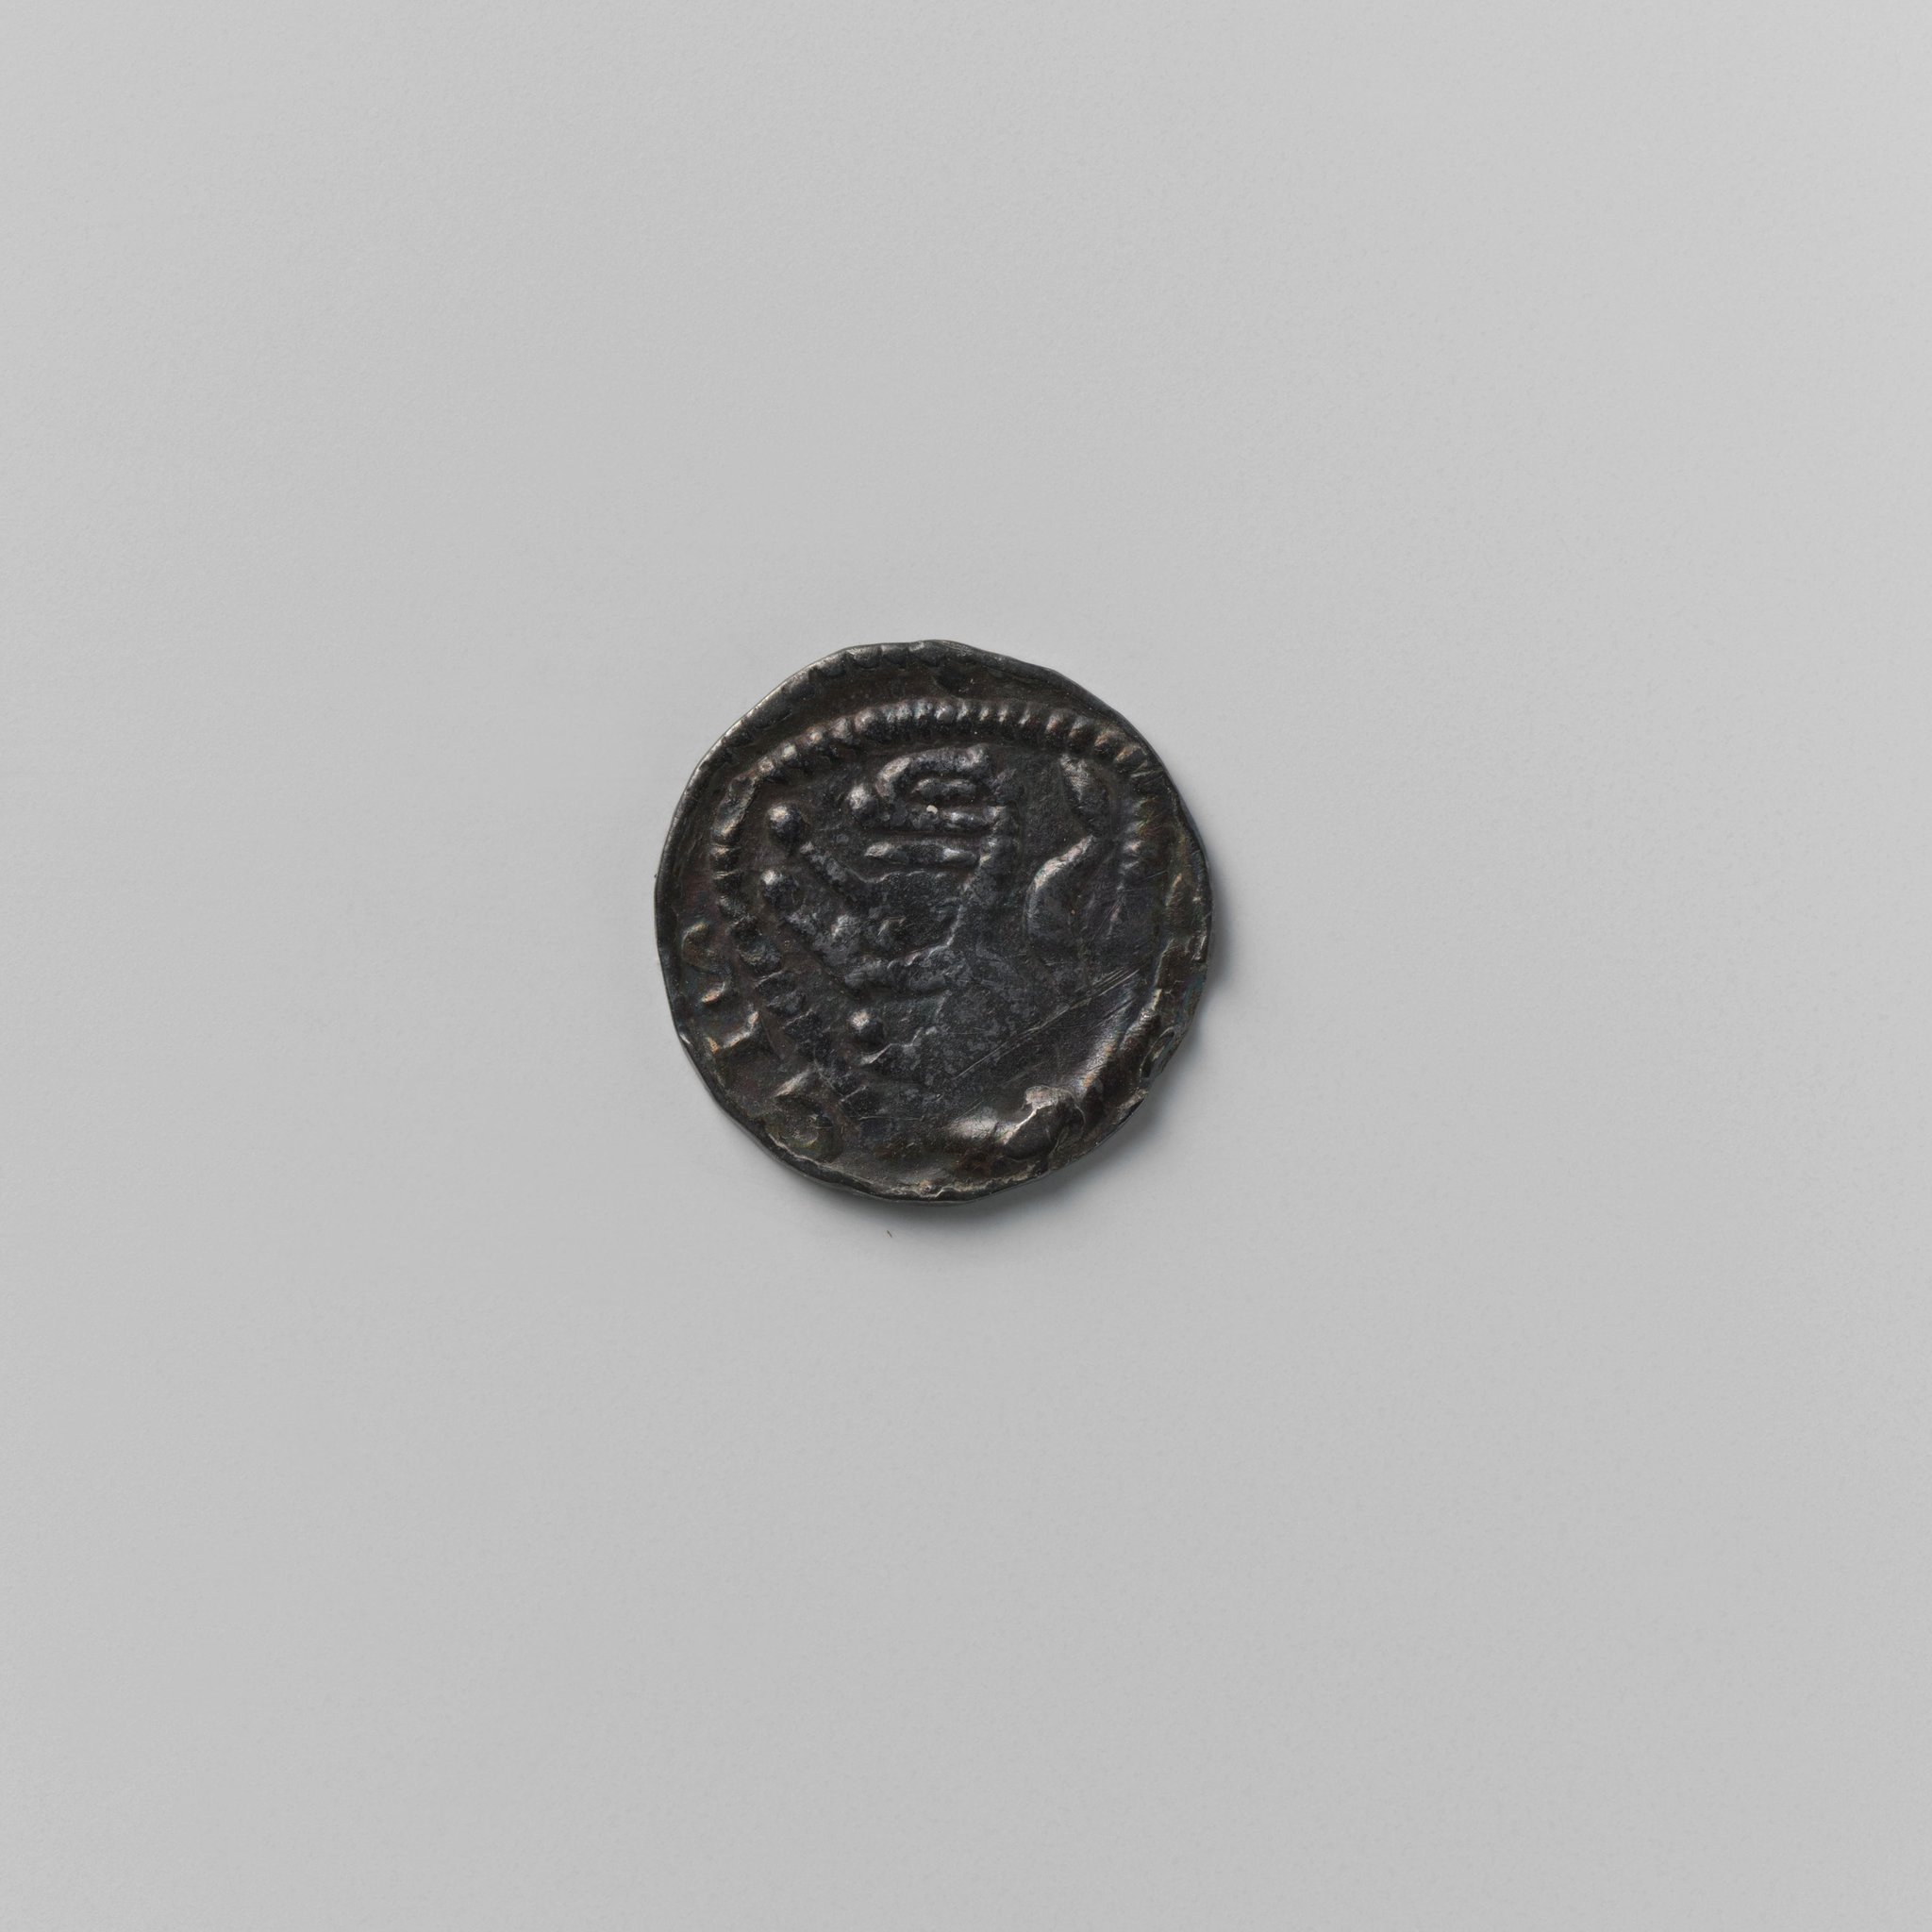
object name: coin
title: Penning uit Brabant van Hendrik II/III, 1235-1261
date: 1235-1261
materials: silver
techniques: striking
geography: tienen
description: Voorzijde: in een punt uitlopend wapenschild met leeuw. Keerzijde: versierd kruis, in de hoeken letters.